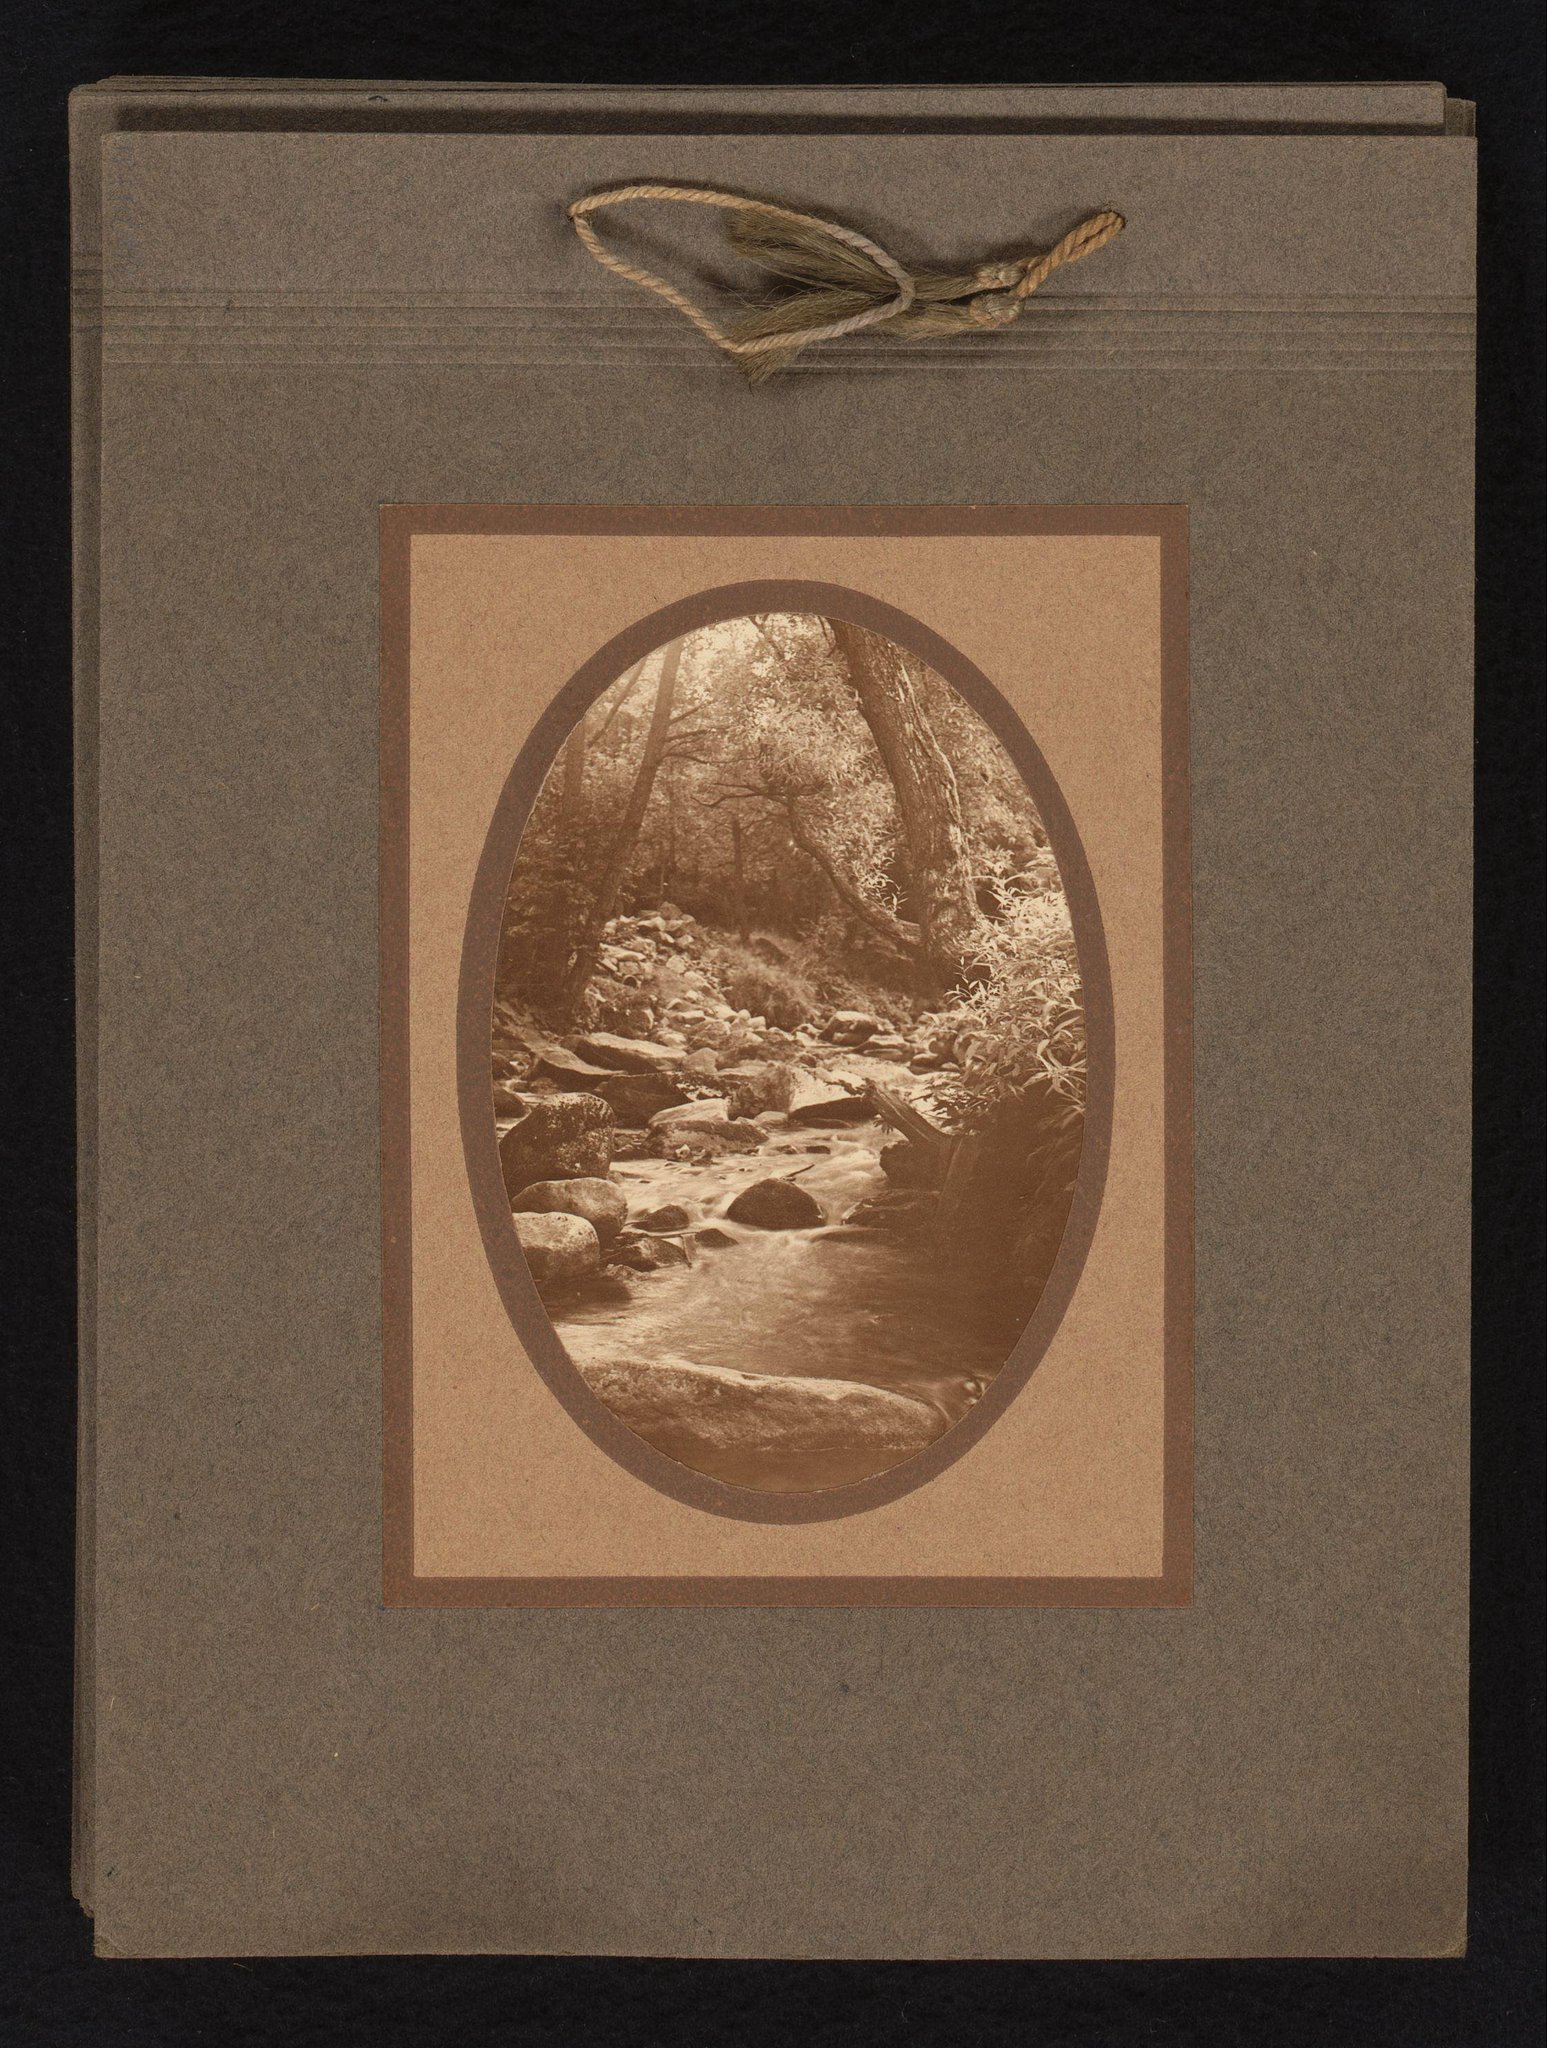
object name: scrapbook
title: Fotoalbum met 24 foto's van voornamelijk landschappen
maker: Anonymous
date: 1880-1930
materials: cardboard, photographic support, fiber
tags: trees, child, landscapes with waters, waterscapes, seascapes (in the temperate zone), forest, wood, street, still life of miscellaneous objects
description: Fotoalbum met 24 pagina's en 24 foto's. Het album bevat foto's van verschillende landschappen, veelal bossen of bospaden, maar ook beken of ander water en straatgezichten.